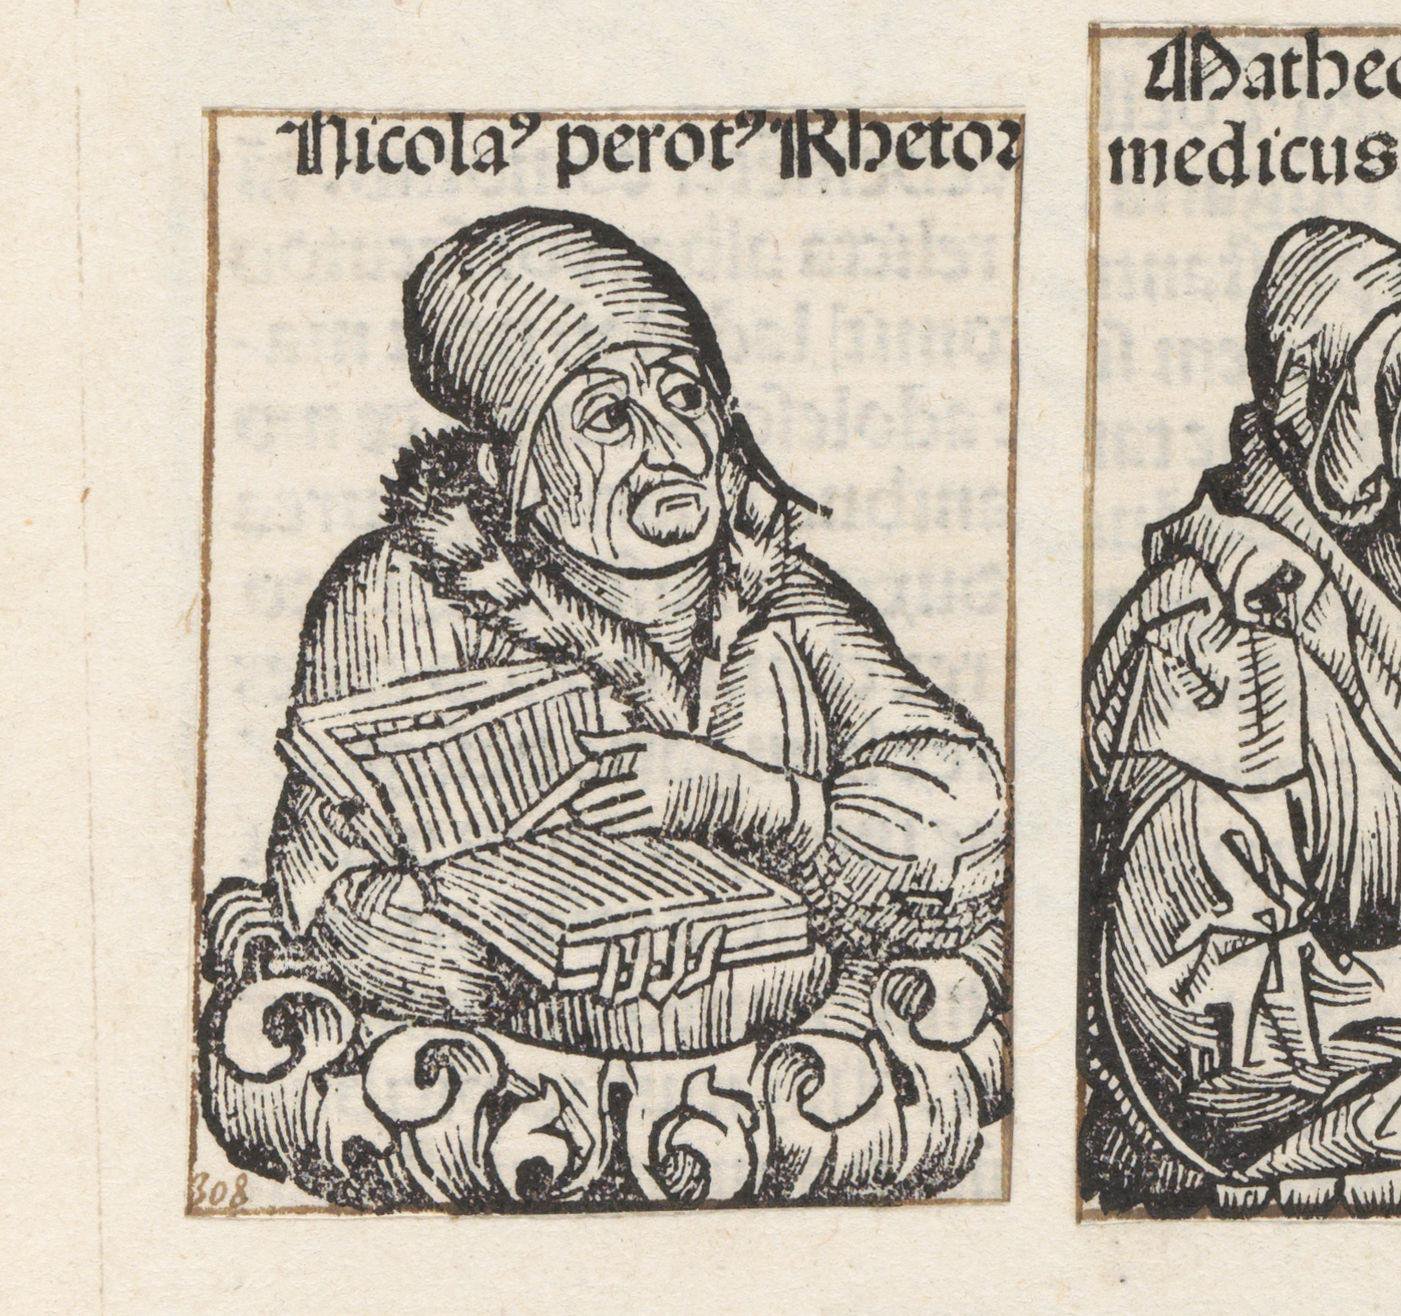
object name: album leaf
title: Nicola[us] perot[us] Rhetor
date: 1493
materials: paper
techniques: letterpress printing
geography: nuremberg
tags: fano, filoloog, niccolò perotti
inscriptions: inscription: ‘308’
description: De houtsnede wordt herhaaldelijk gebruikt als boekillustratie in de Liber Chronicarum (of Neurenbergkroniek) van Hartmann Schedel, verschenen in het Latijn en Duits in 1493. Zie de Latijnse uitgave, folio 252v.